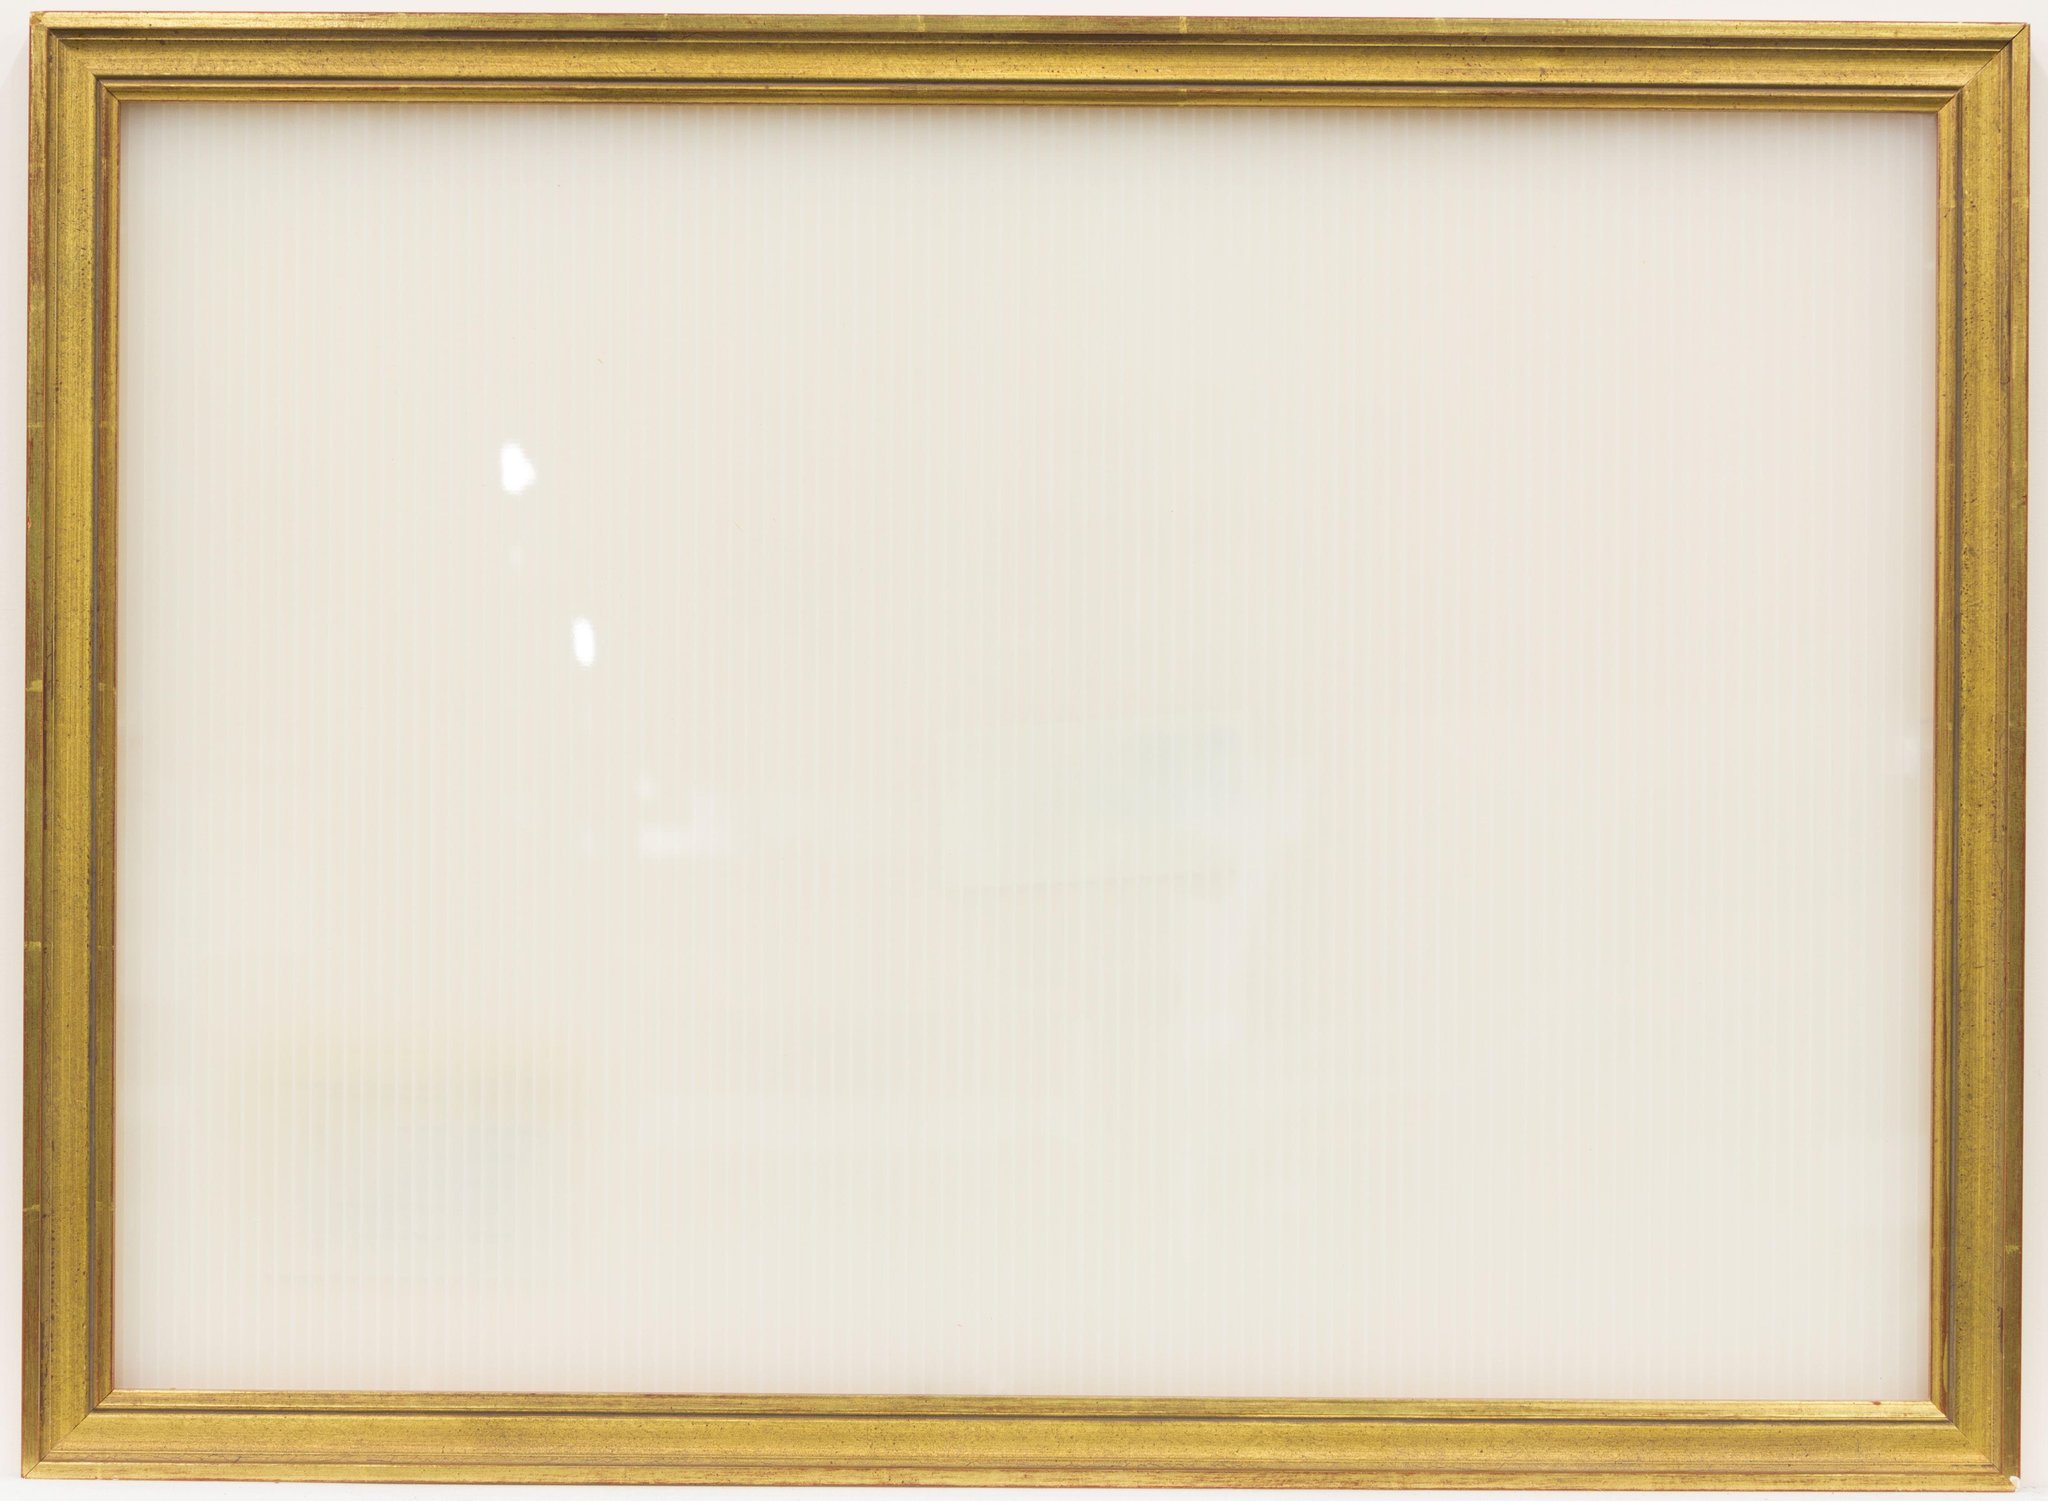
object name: frame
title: Vergulde profiellijst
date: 1990-2009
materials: wood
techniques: gilding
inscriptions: label: ‘THE NATIONAL GALLERY // Exhibition: Aelbert Cuyp // ... (zie foto) // Title Dordrecht Viewed from the East’, label: ‘National Gallery of Art // Washington D.C. // Exhibition Aelbert Cuyp // ... (zie foto) // Title Dordrecht Viewed from the East’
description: De lijst bevat een perspex plaatje. Voor pendanten zie RP-L-325, 326, 327 en 441.